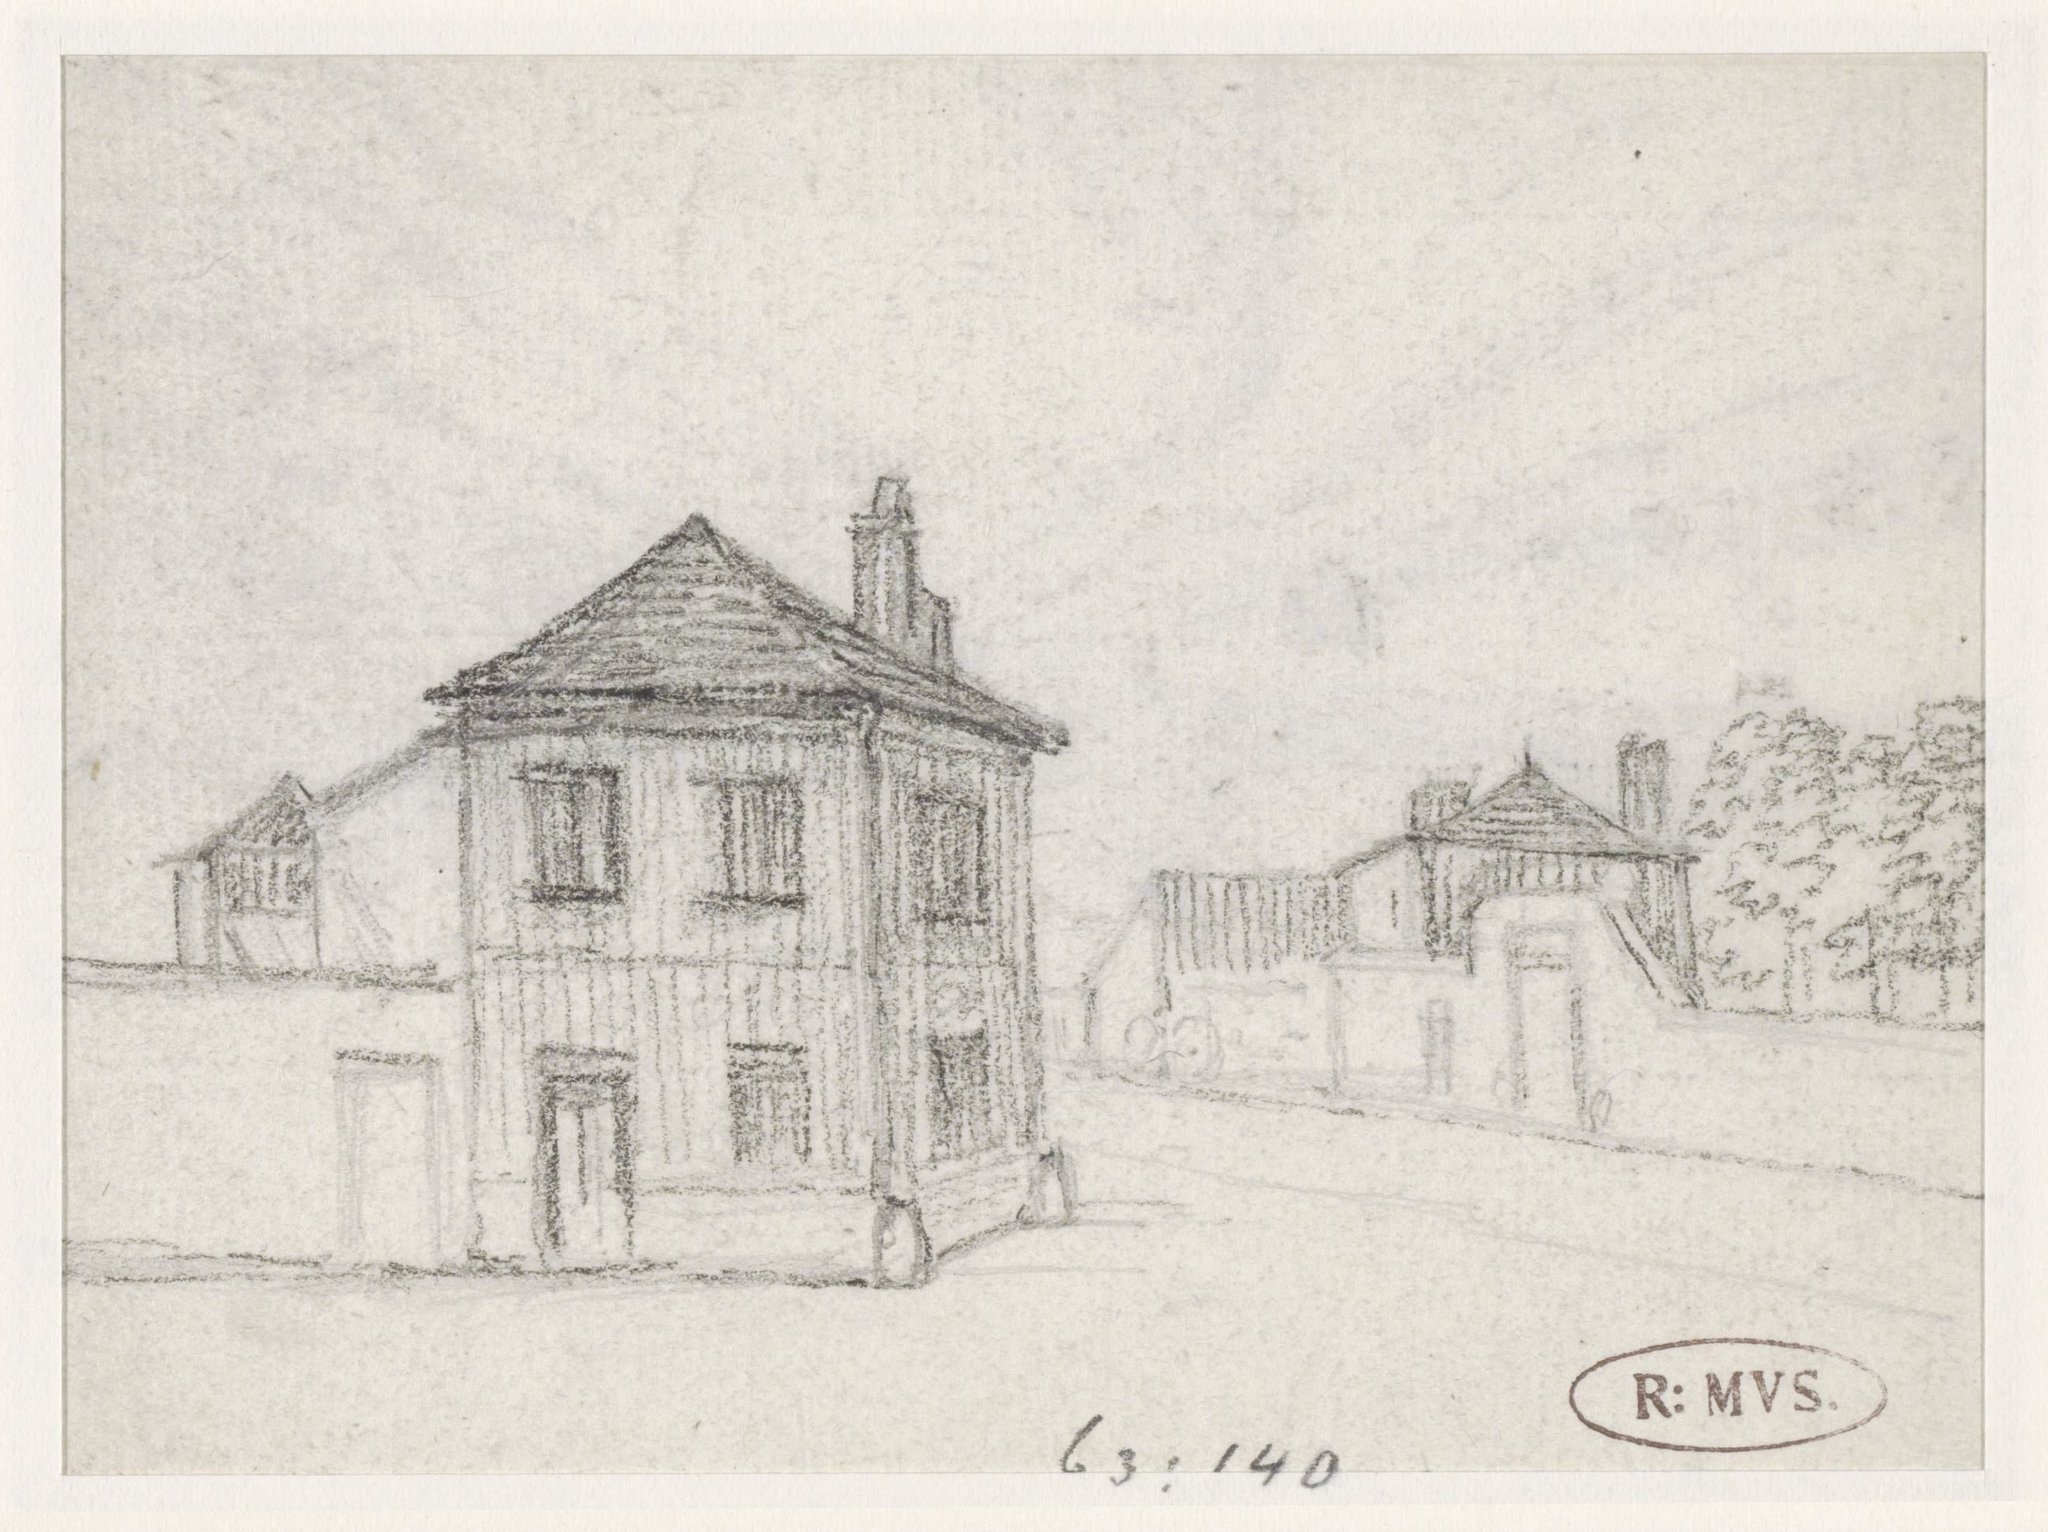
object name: drawing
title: Huizen aan de rand van de stad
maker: georges michel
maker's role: draughtsman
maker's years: 1763-1843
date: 1773-1843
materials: chalk, paper, pencil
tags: outskirts of city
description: Een van 120 tekeningen, afkomstig uit een 19e eeuws album met tekeningen van Georges Michel.